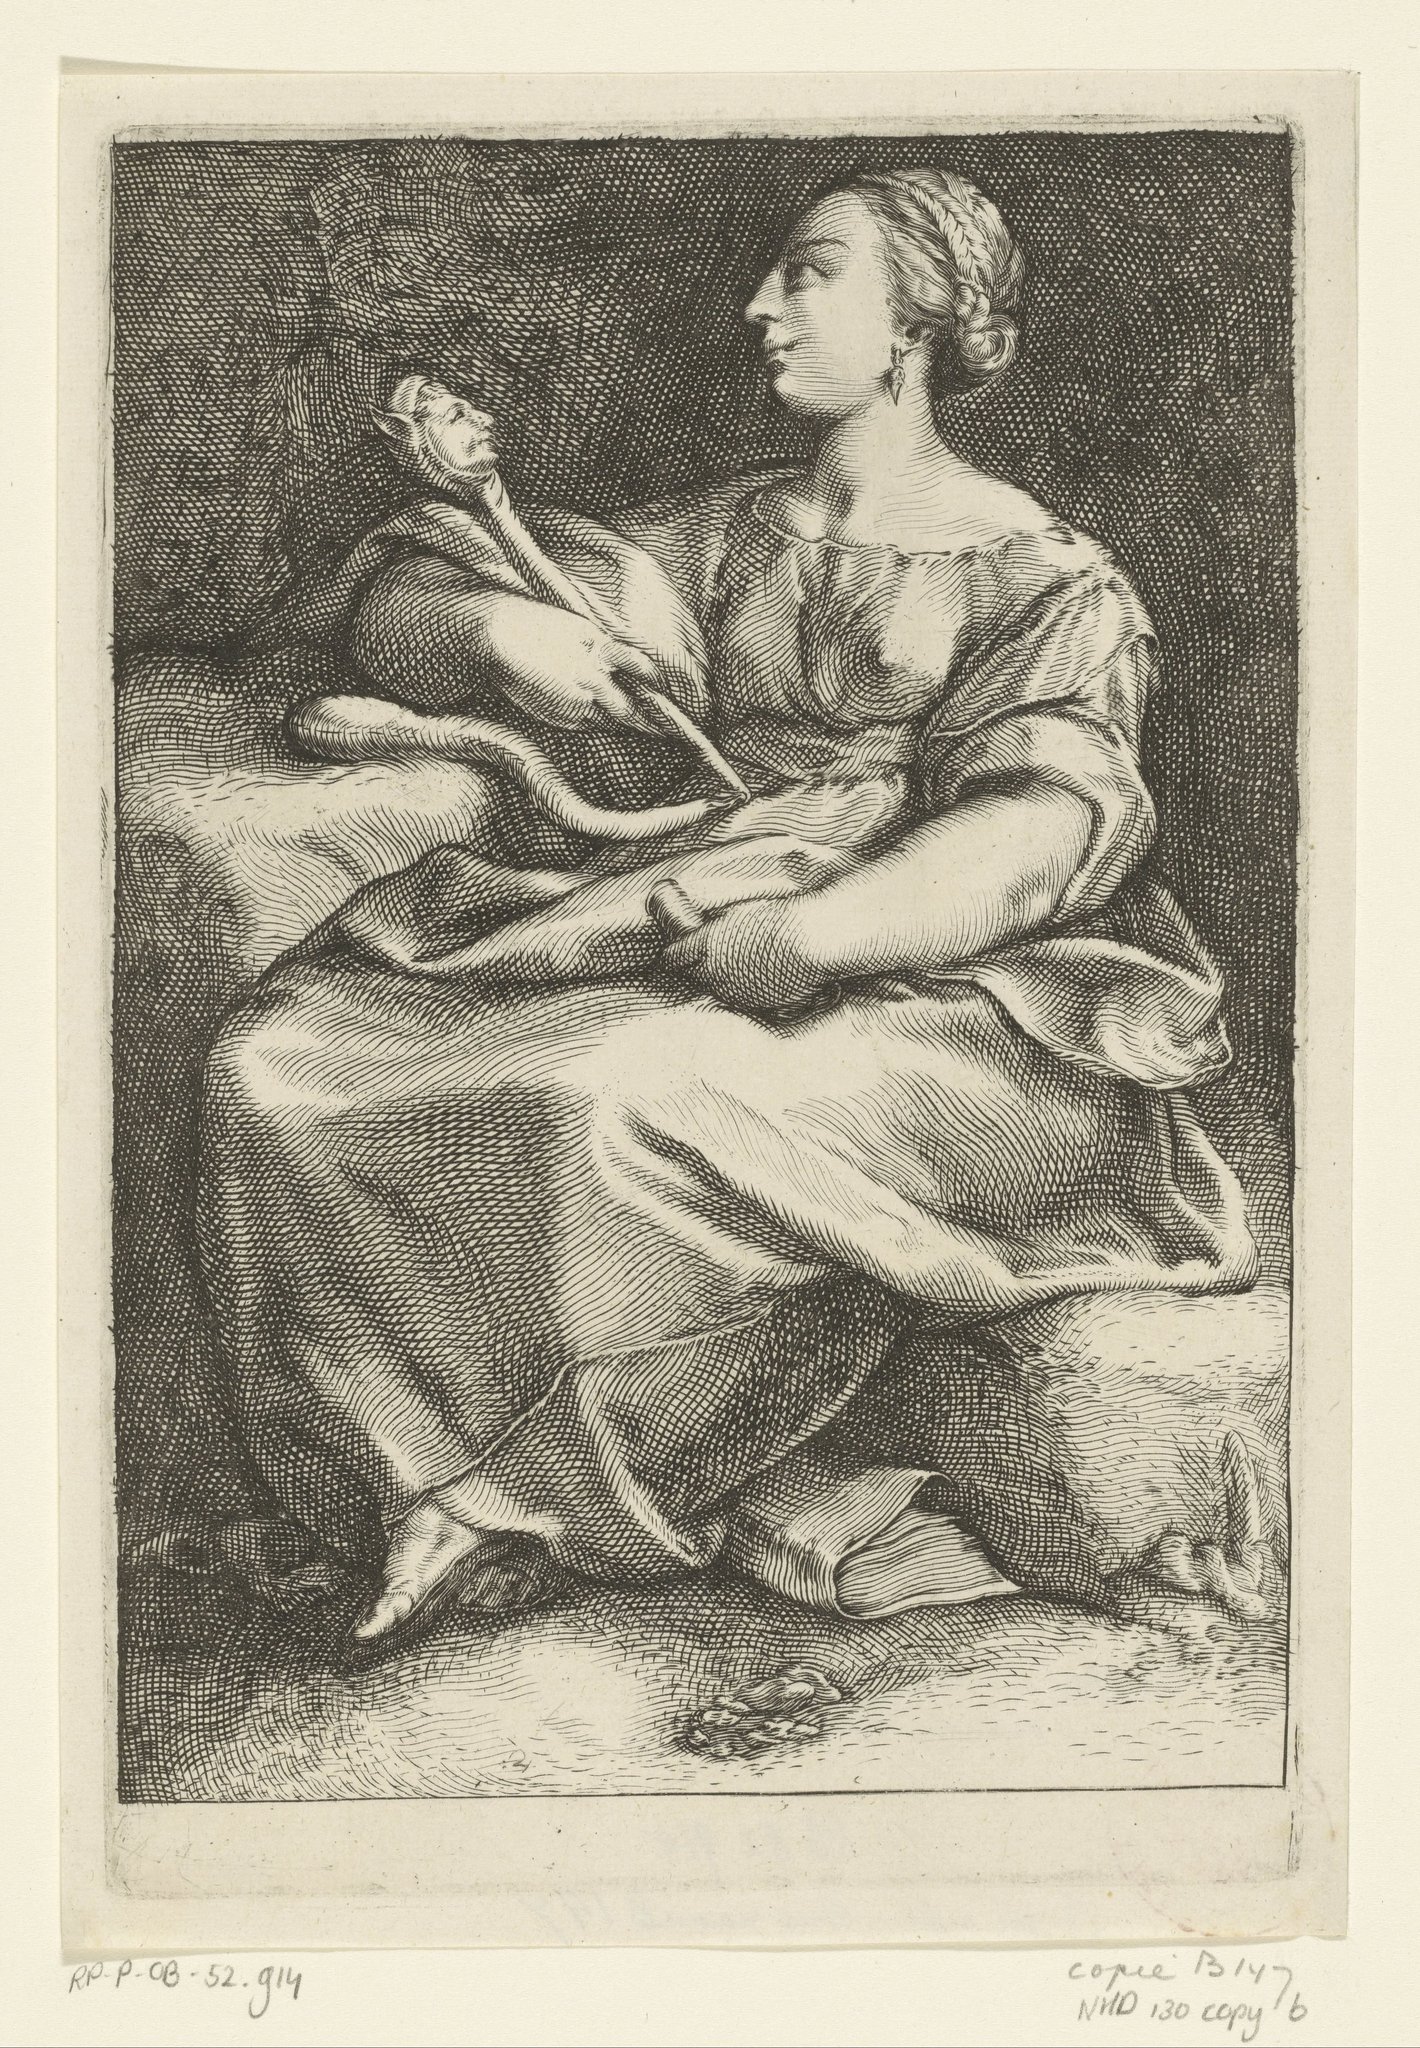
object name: print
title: Thalia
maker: Anonymous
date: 1592-1667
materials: paper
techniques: drypoint, engraving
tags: thalia (one of the muses); 'talia' (ripa)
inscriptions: collector's mark: Lugt 240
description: Thalia, de muze van het blijspel en de herderspoëzie, zit met een narrenmasker in haar hand en aan haar voeten een boek. Haar haren zijn gevlochten.